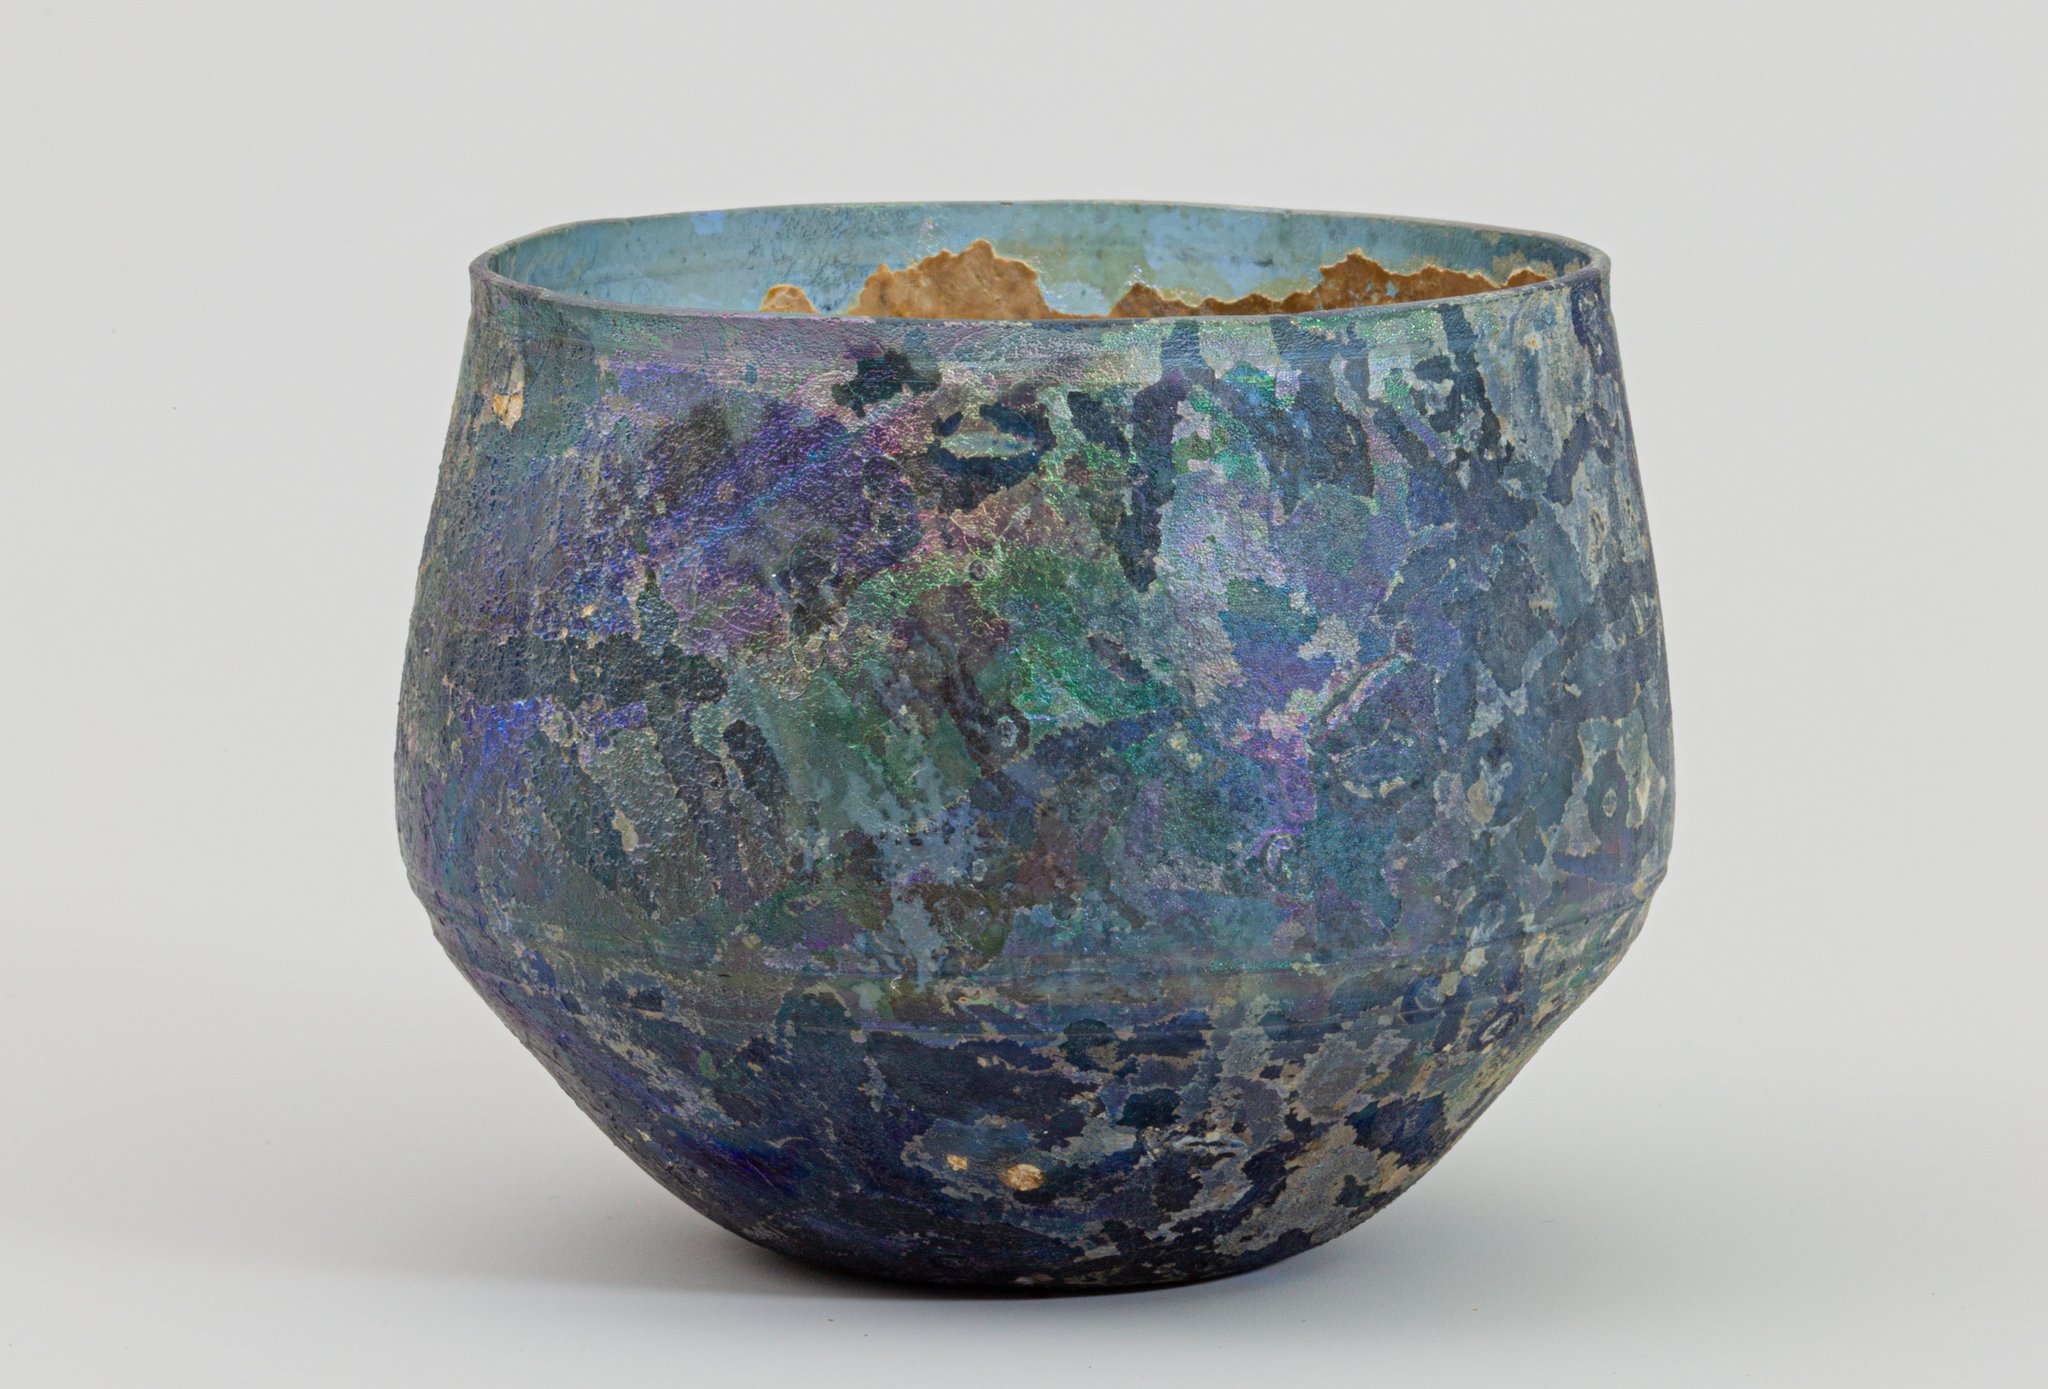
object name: bowl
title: Glass bowl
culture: roman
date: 1-100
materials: glass